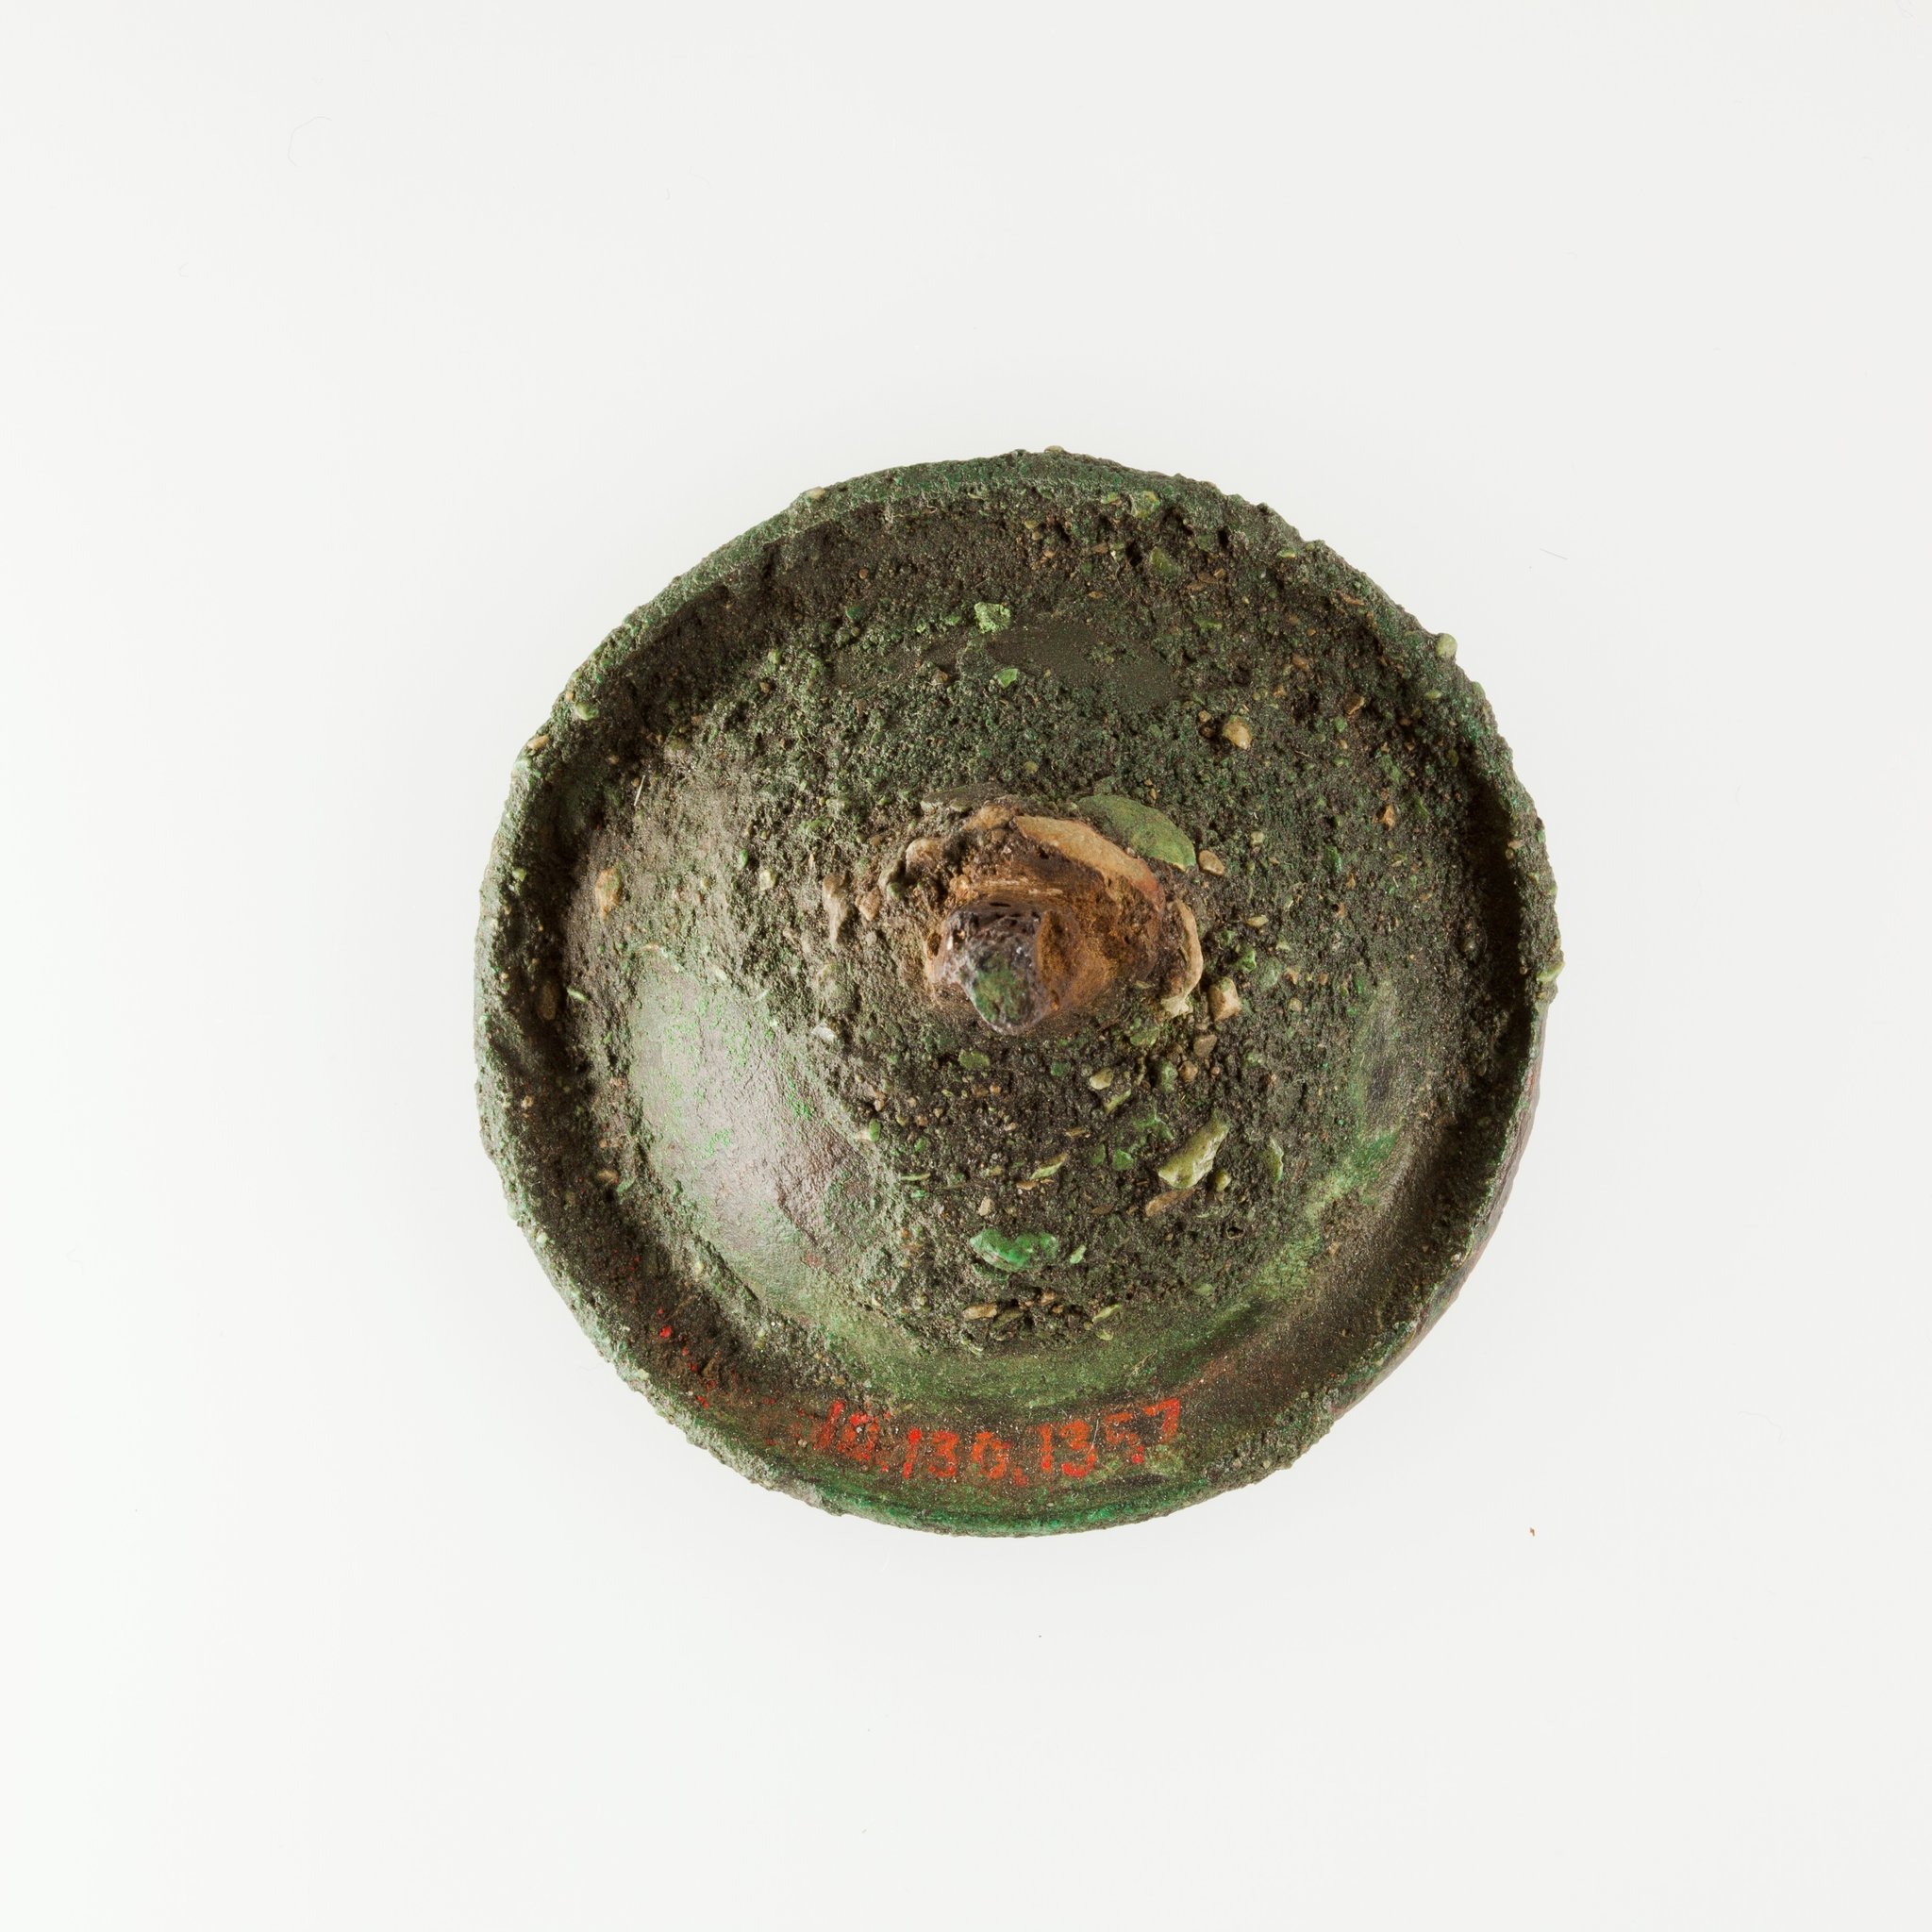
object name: music, cymbal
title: Cymbal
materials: copper alloy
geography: egypt